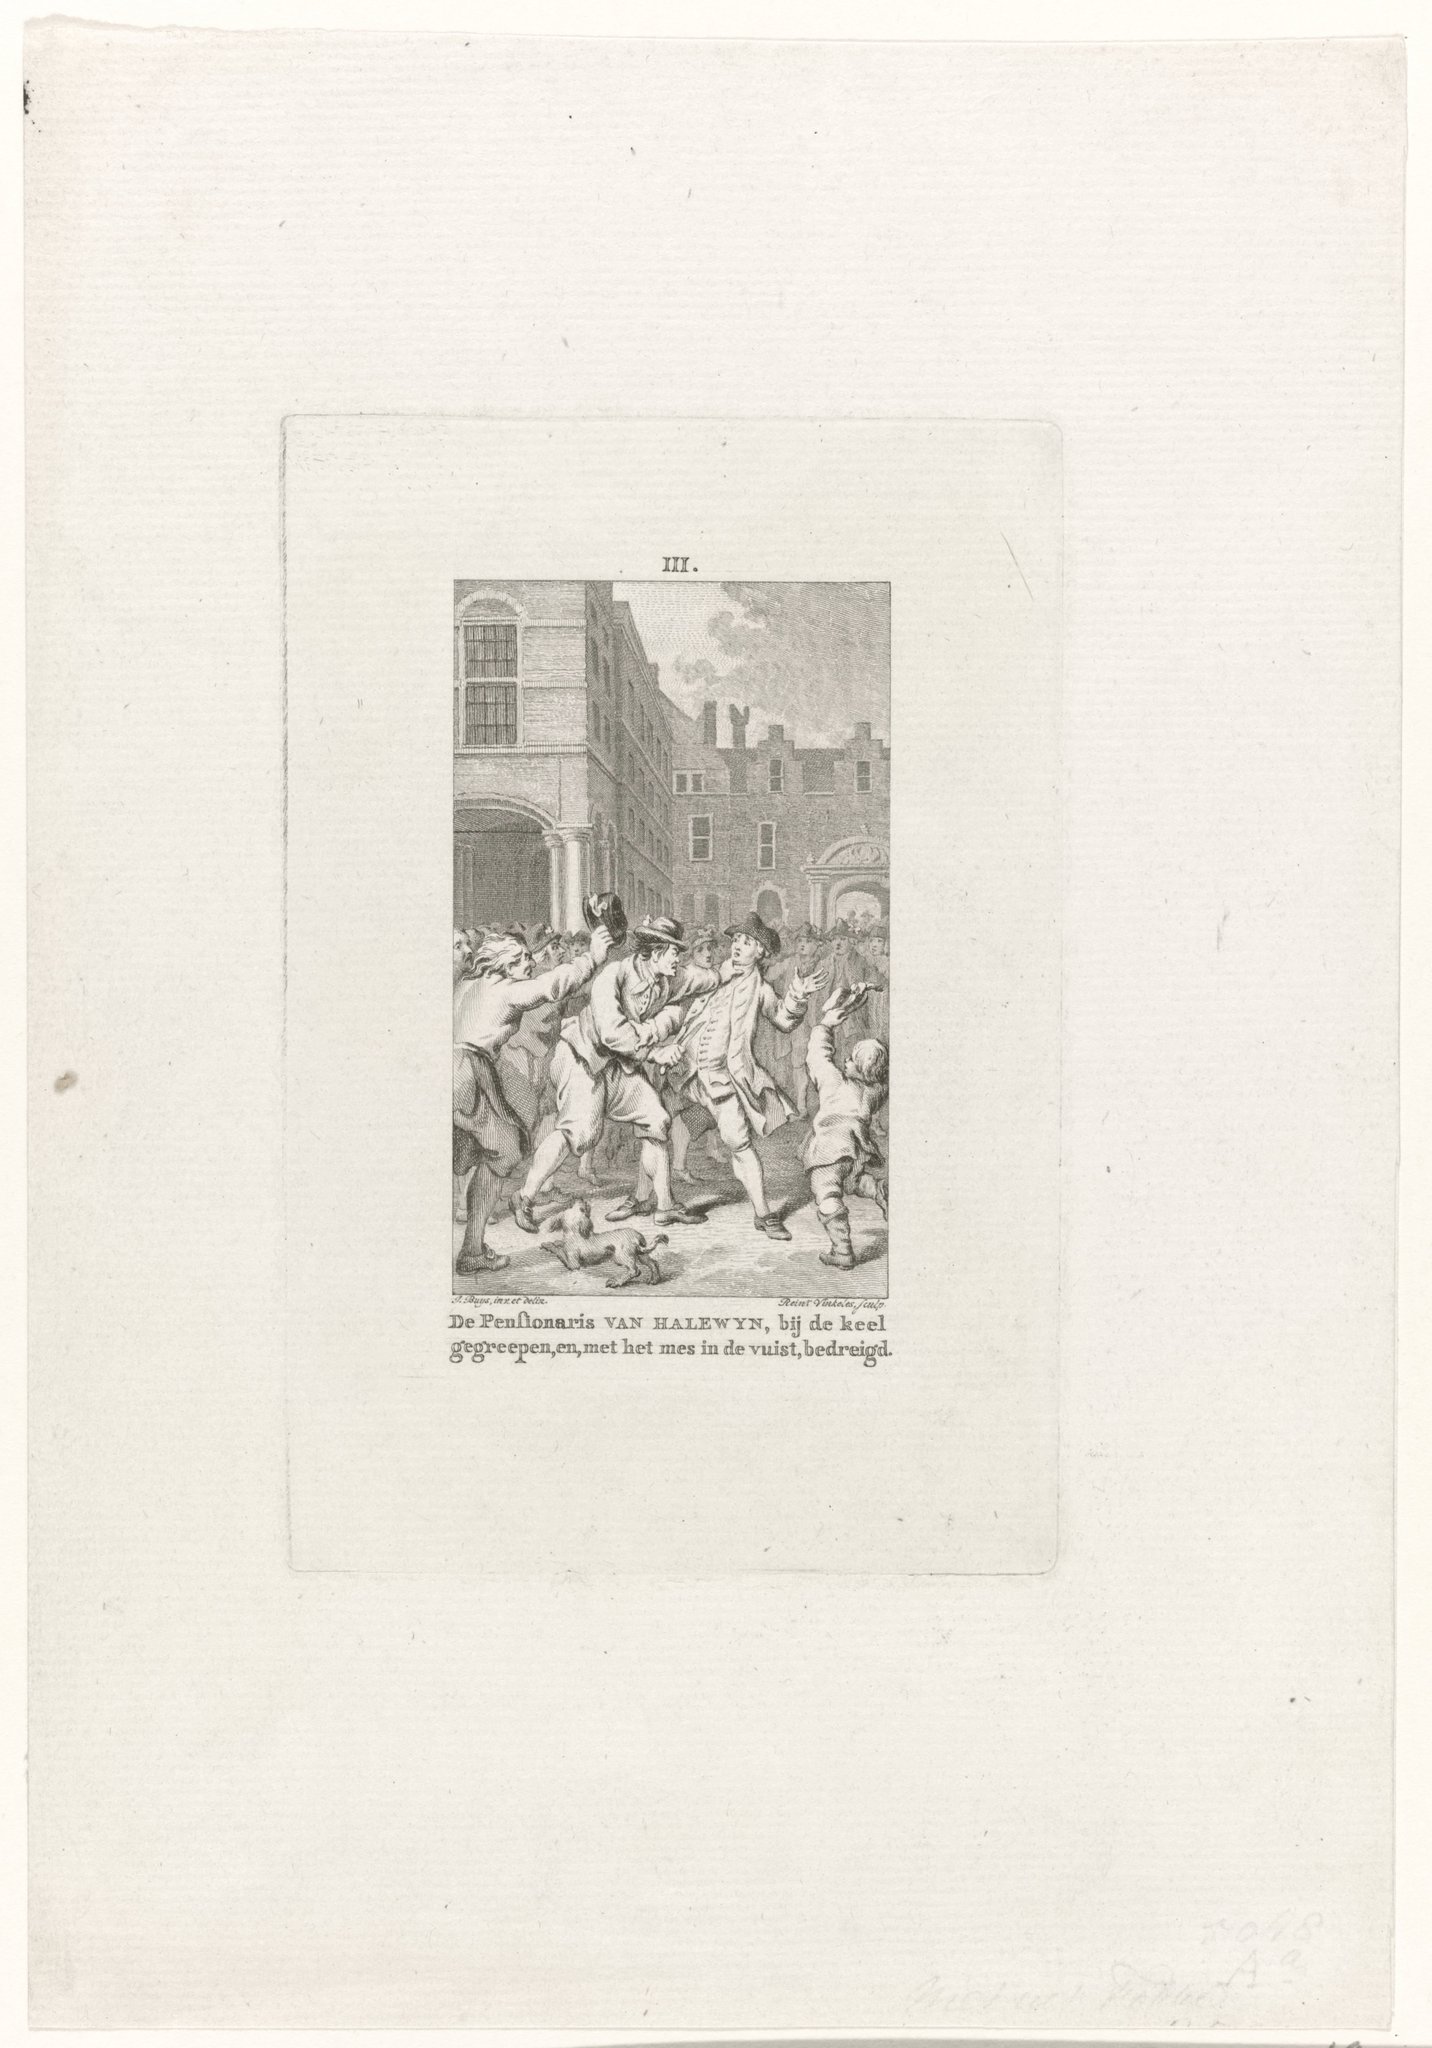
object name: history print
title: De pensionaris van Dordrecht bedreigd, 1747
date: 1782-1784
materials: paper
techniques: engraving, etching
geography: northern netherlands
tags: fighting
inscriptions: collector's mark: Lugt 2228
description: Op het Binnenhof wordt de pensionaris van Dordrecht bedreigd door een woedende Oranjeklanten omdat hij niet beloofde meer te werken aan de verheffing van prins Willem IV tot erfstadhouder, 1747. Bovenaan genummerd: III.